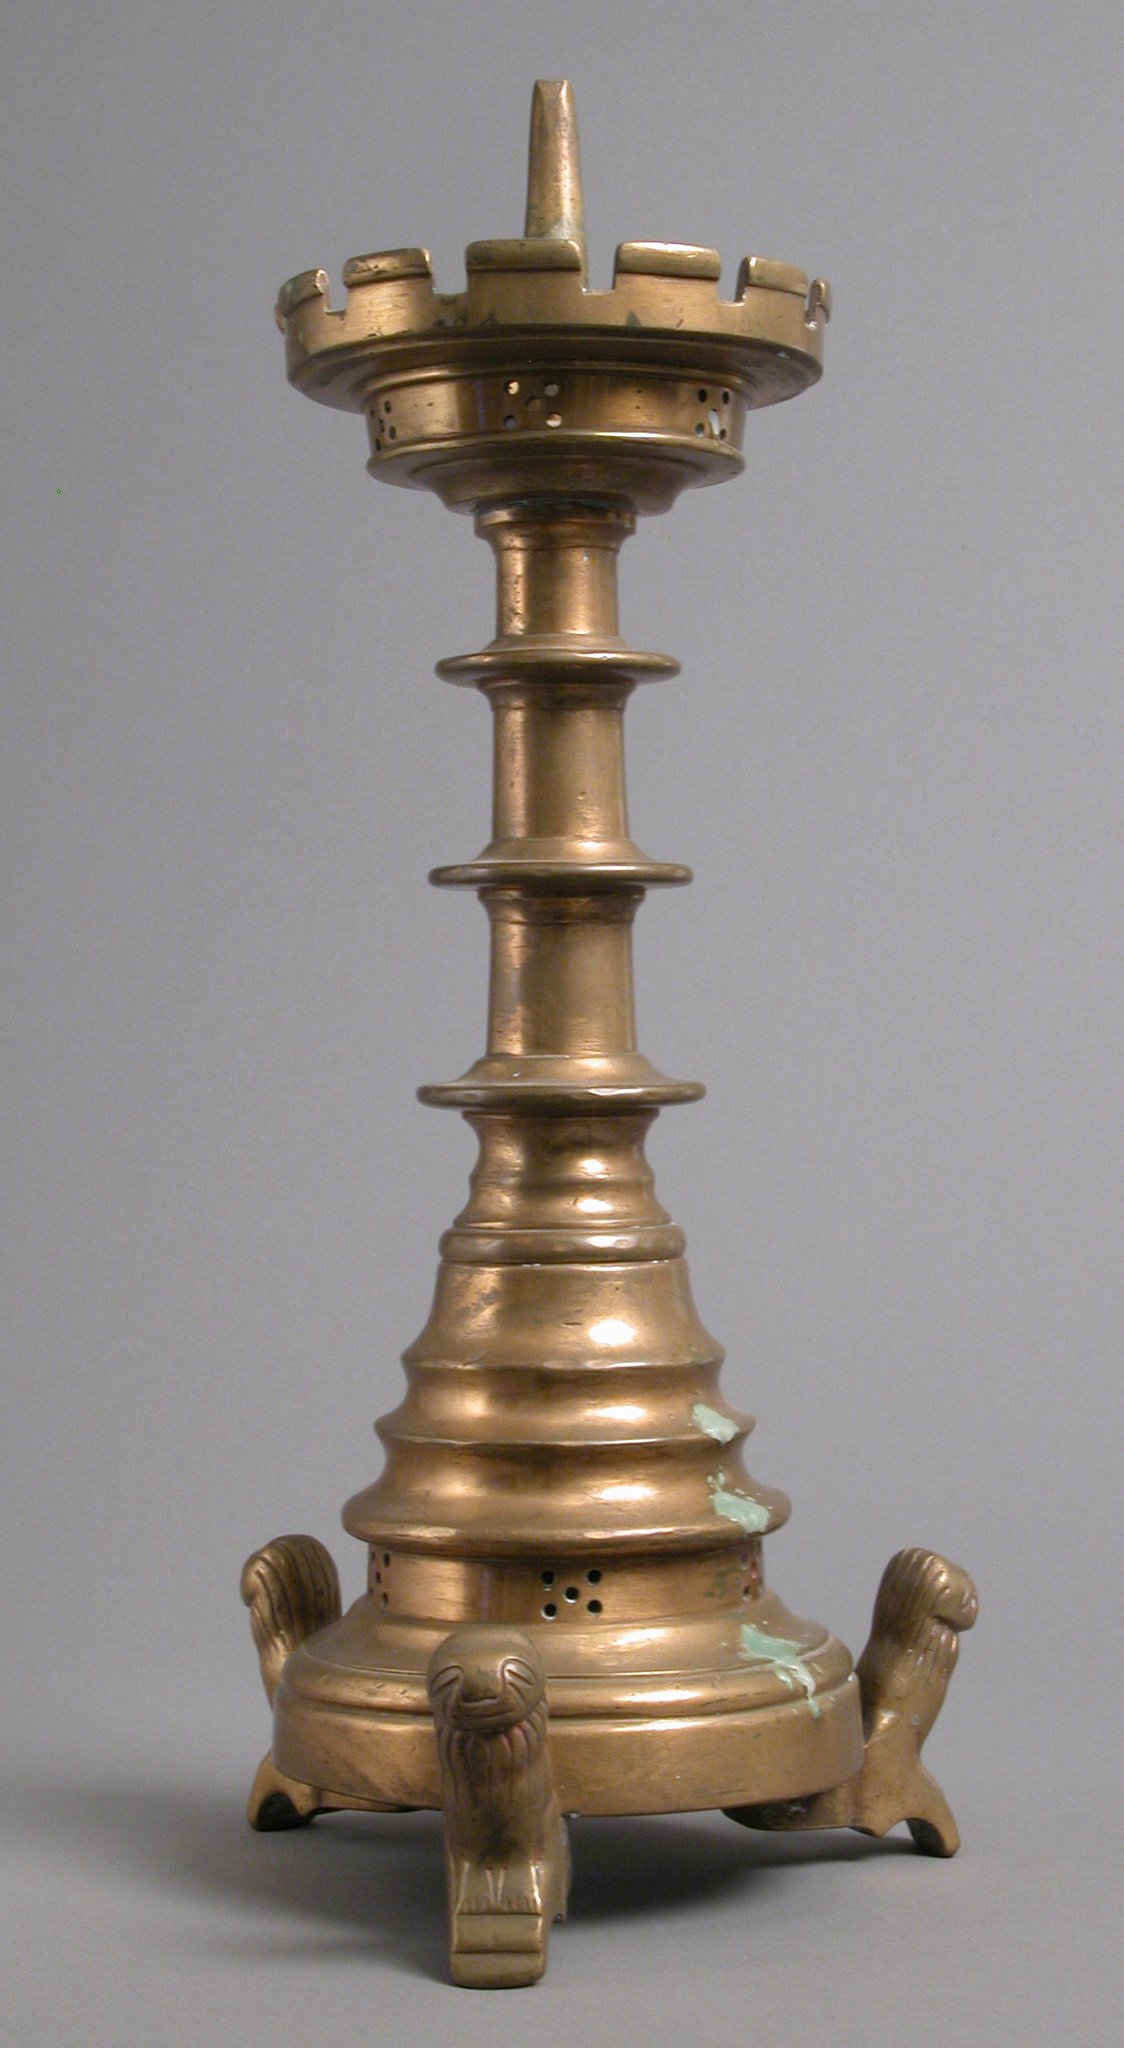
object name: candlestick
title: Candlestick, Pricket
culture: south netherlandish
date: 1401-1500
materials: brass